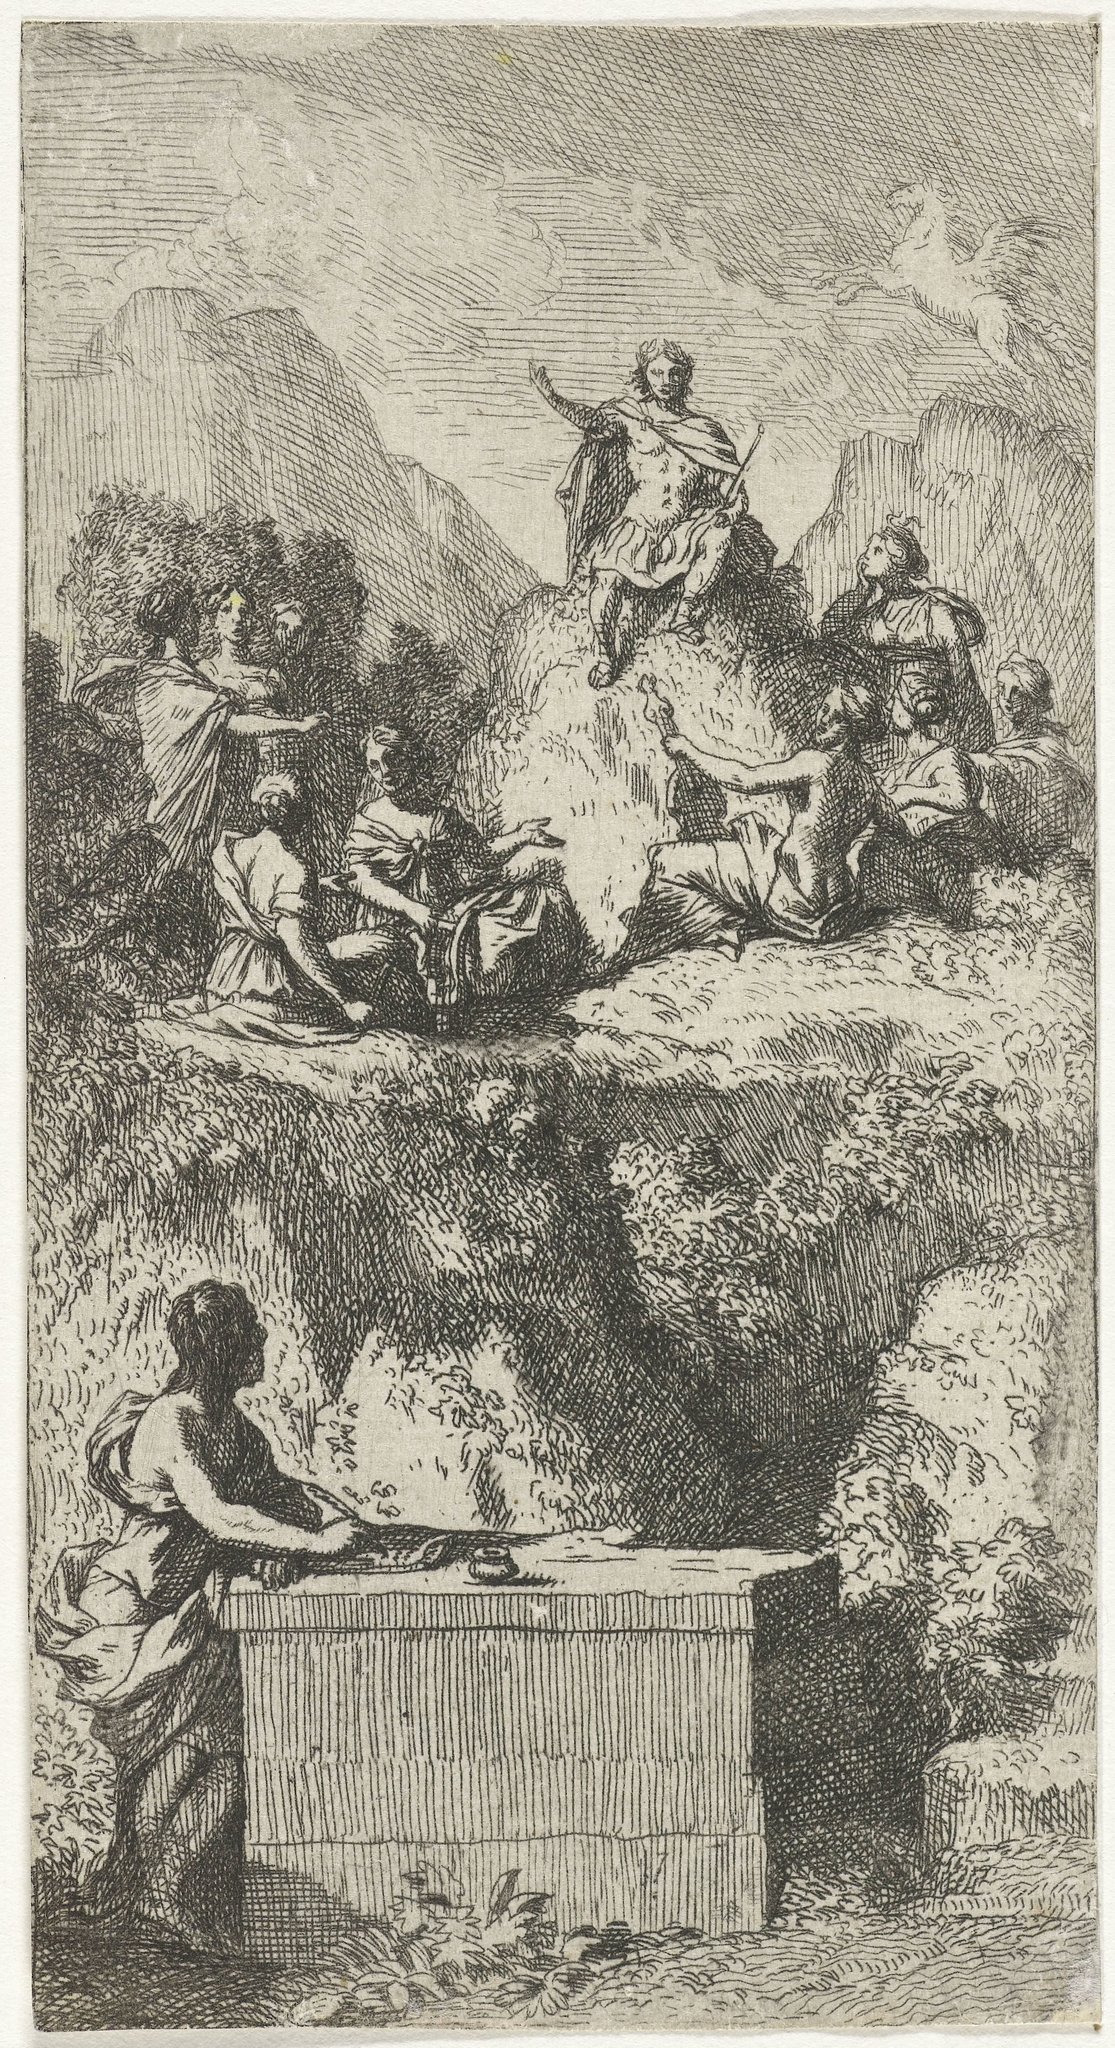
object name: print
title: Apollo op de berg Parnassus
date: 1669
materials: paper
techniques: etching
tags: pegasus, the winged horse, (story of) apollo (phoebus), parnassus, sacred to apollo musagetes, inspiration of the poet; 'furore poetico' (ripa)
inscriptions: collector's mark: Lugt 2228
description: Apollo zit, omgeven door muzen, op de berg Parnassus. In zijn linkerhand houdt hij een scepter vast, met zijn rechterhand wijst hij hemelwaarts. Rechts van hem is Pegasus in de lucht verschenen. Lager op de berg staat een dichter te schrijven en kijkt daarbij ter inspiratie naar Apollo.